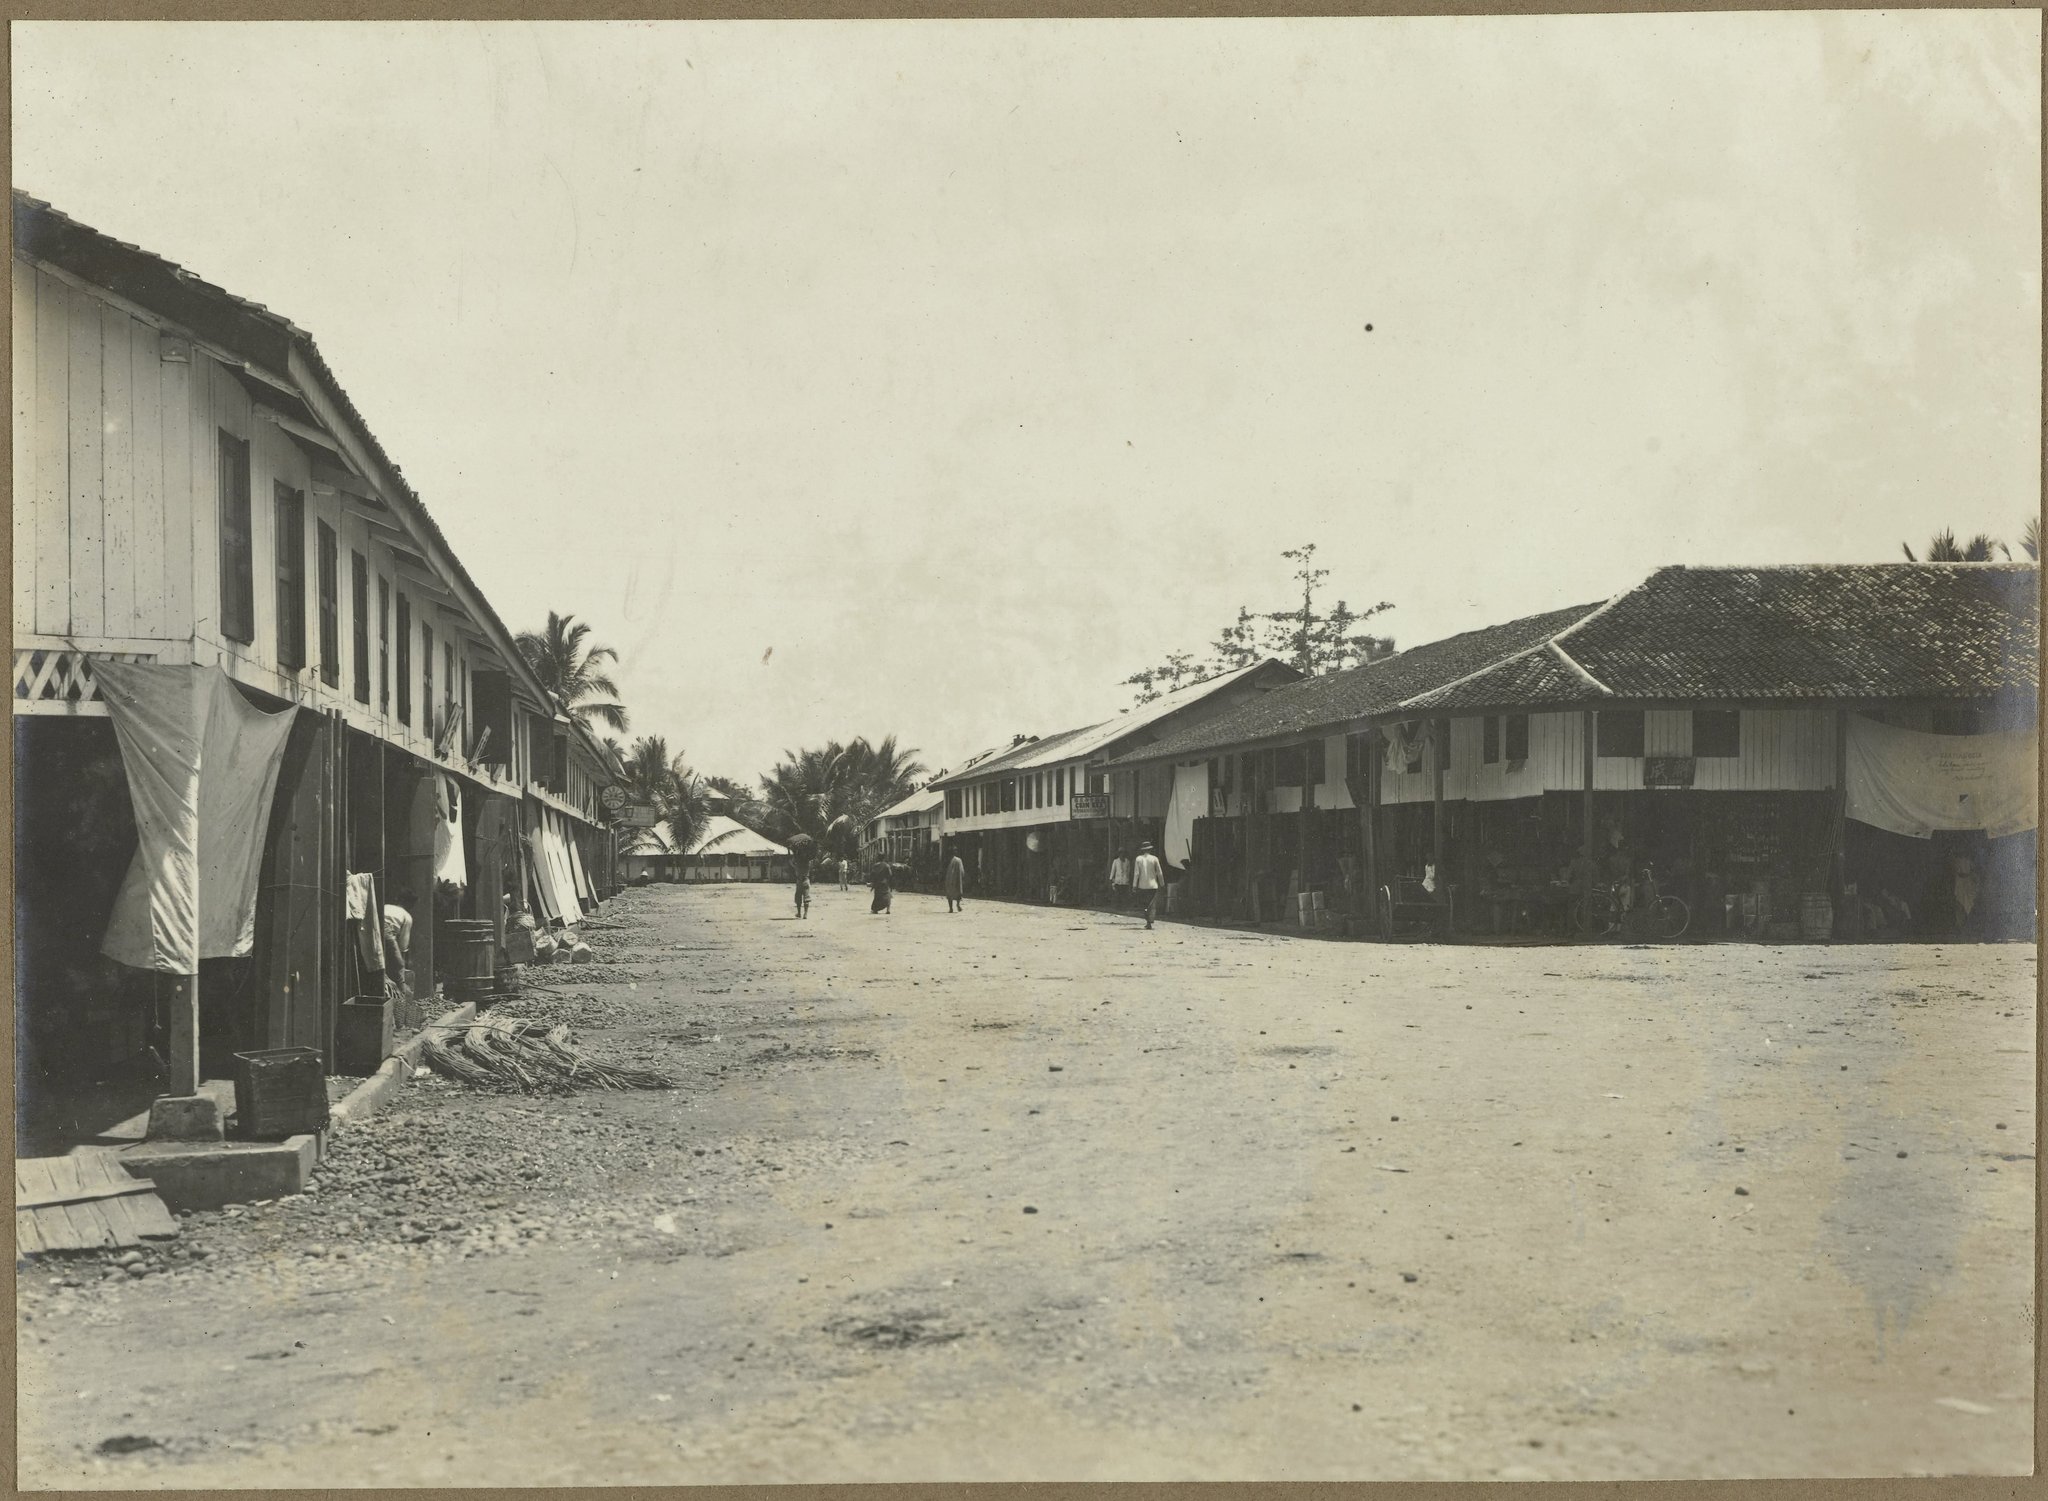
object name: photograph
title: Straatgezicht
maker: Anonymous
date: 1914-1919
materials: photographic support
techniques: gelatin silver print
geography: medan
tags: representation of real building (either existing or having existed), architecture, public road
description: Gezicht in een straat, waarschijnlijk te Medan, met gebouwen die kenmerkend zijn voor de lokale bouwstijl. Foto in het fotoalbum van het Nederlandse architectenbureau en aannemersbedrijf Bennink en Riphagen te Medan in de jaren ca. 1914-1919.